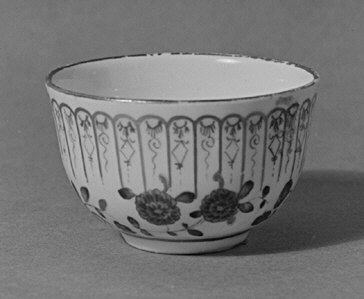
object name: teabowl and saucer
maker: imperial porcelain manufactory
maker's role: manufactory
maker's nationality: austrian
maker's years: 1744-1864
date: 1750-1755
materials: hard paste porcelain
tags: flowers